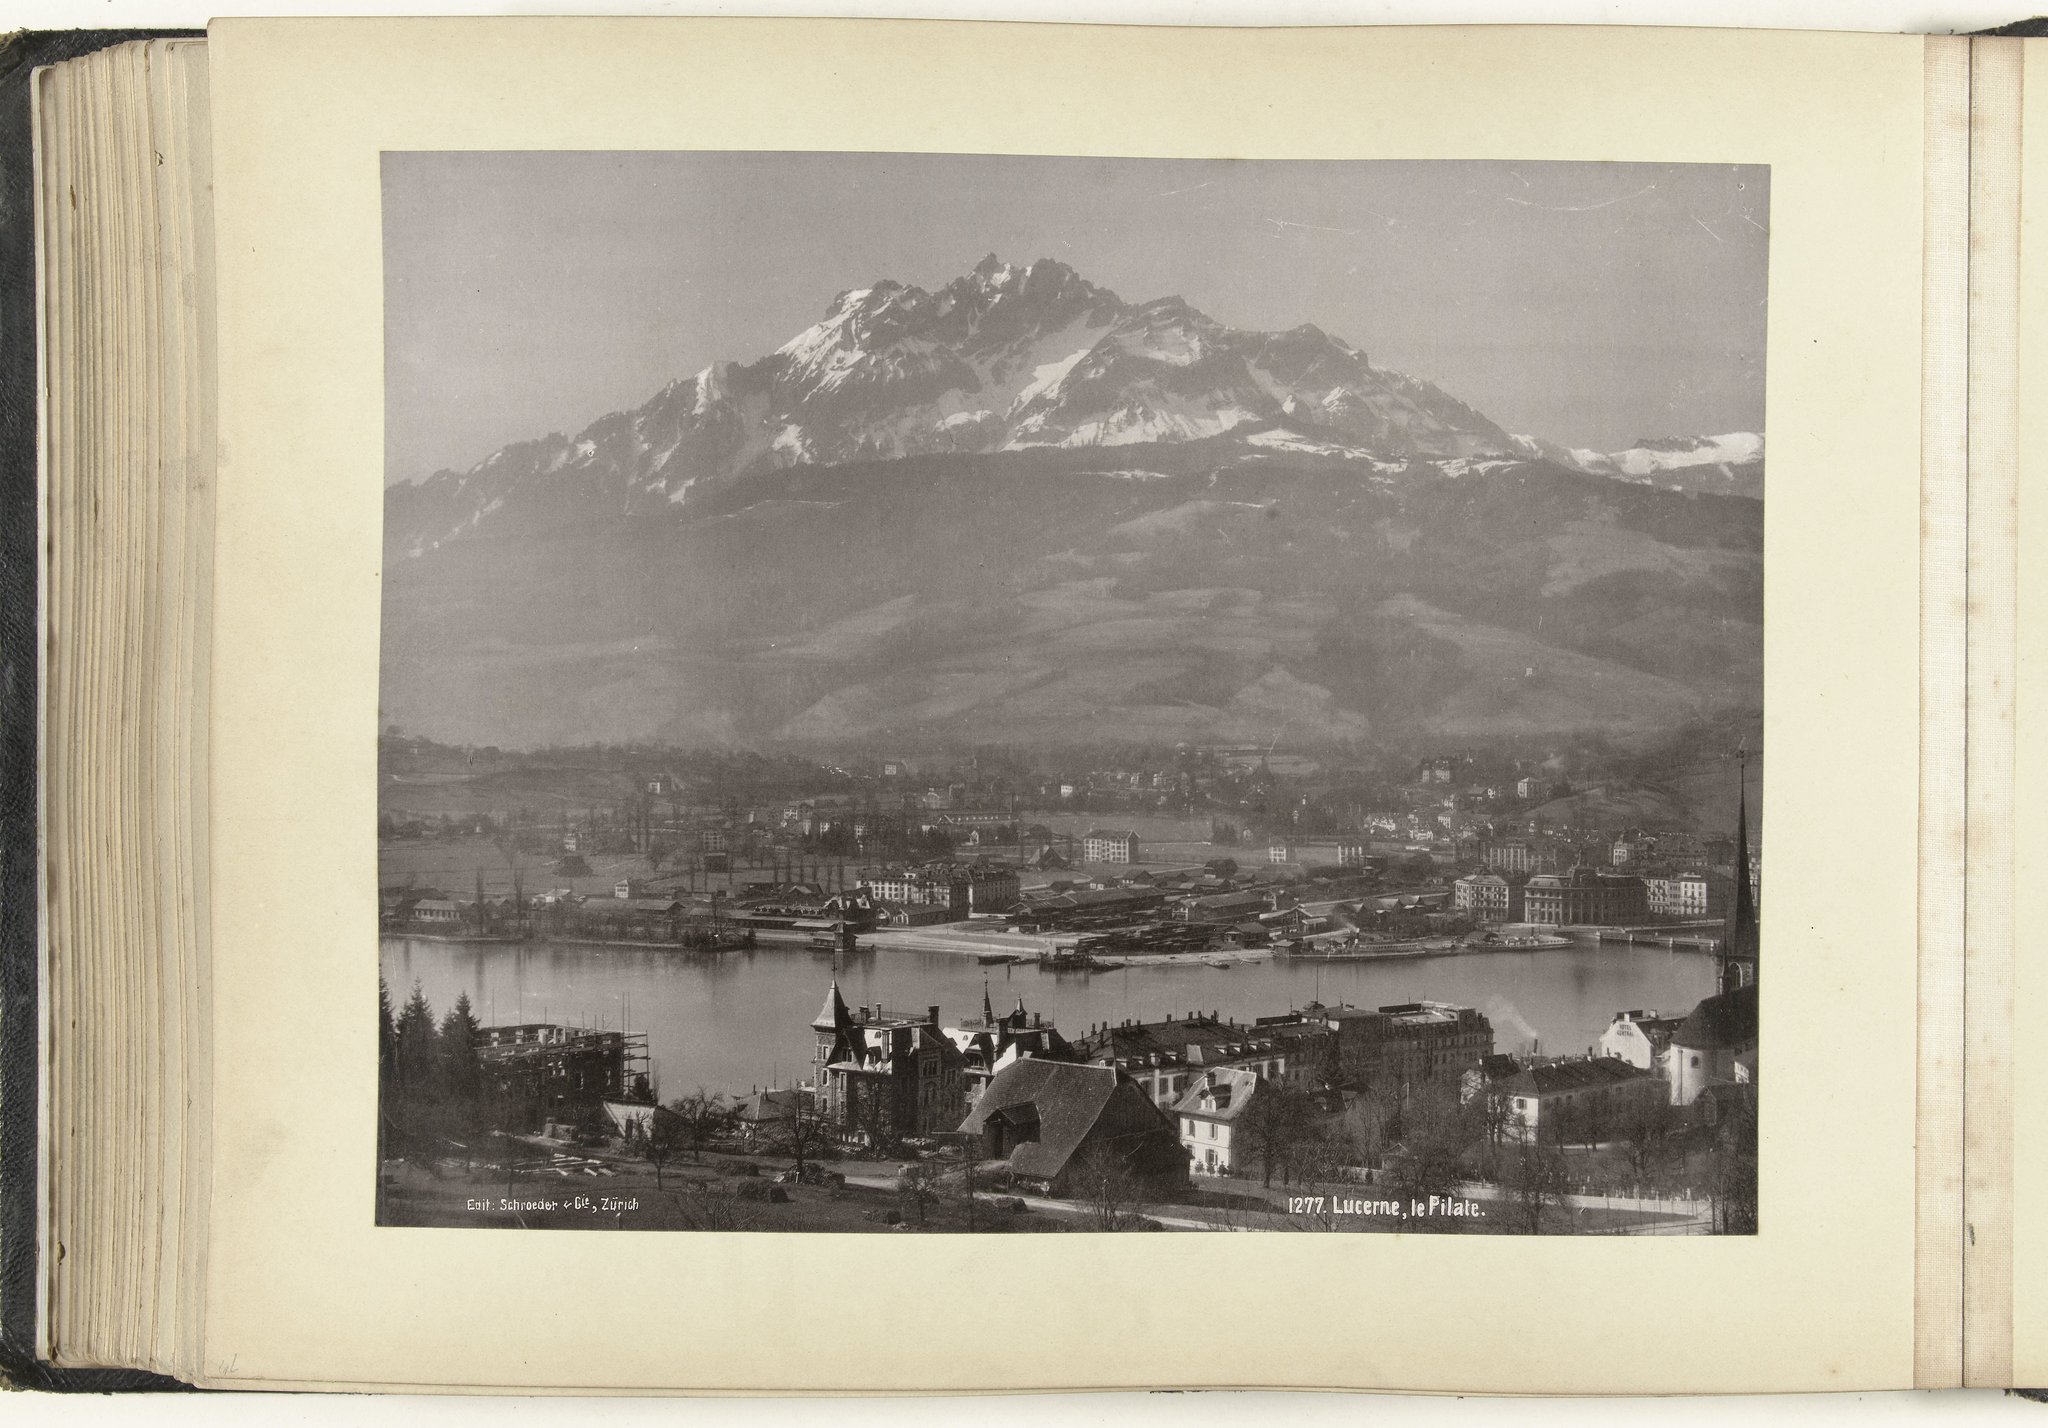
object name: photomechanical print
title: Stadsgezicht over Luzern tegen de achtergrond van de berg Pilatus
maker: Anonymous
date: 1881-1895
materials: paper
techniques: photograph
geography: lucerne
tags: city-view in general; 'veduta', lake, mountain-range, snow peaks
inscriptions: number: ‘1277’